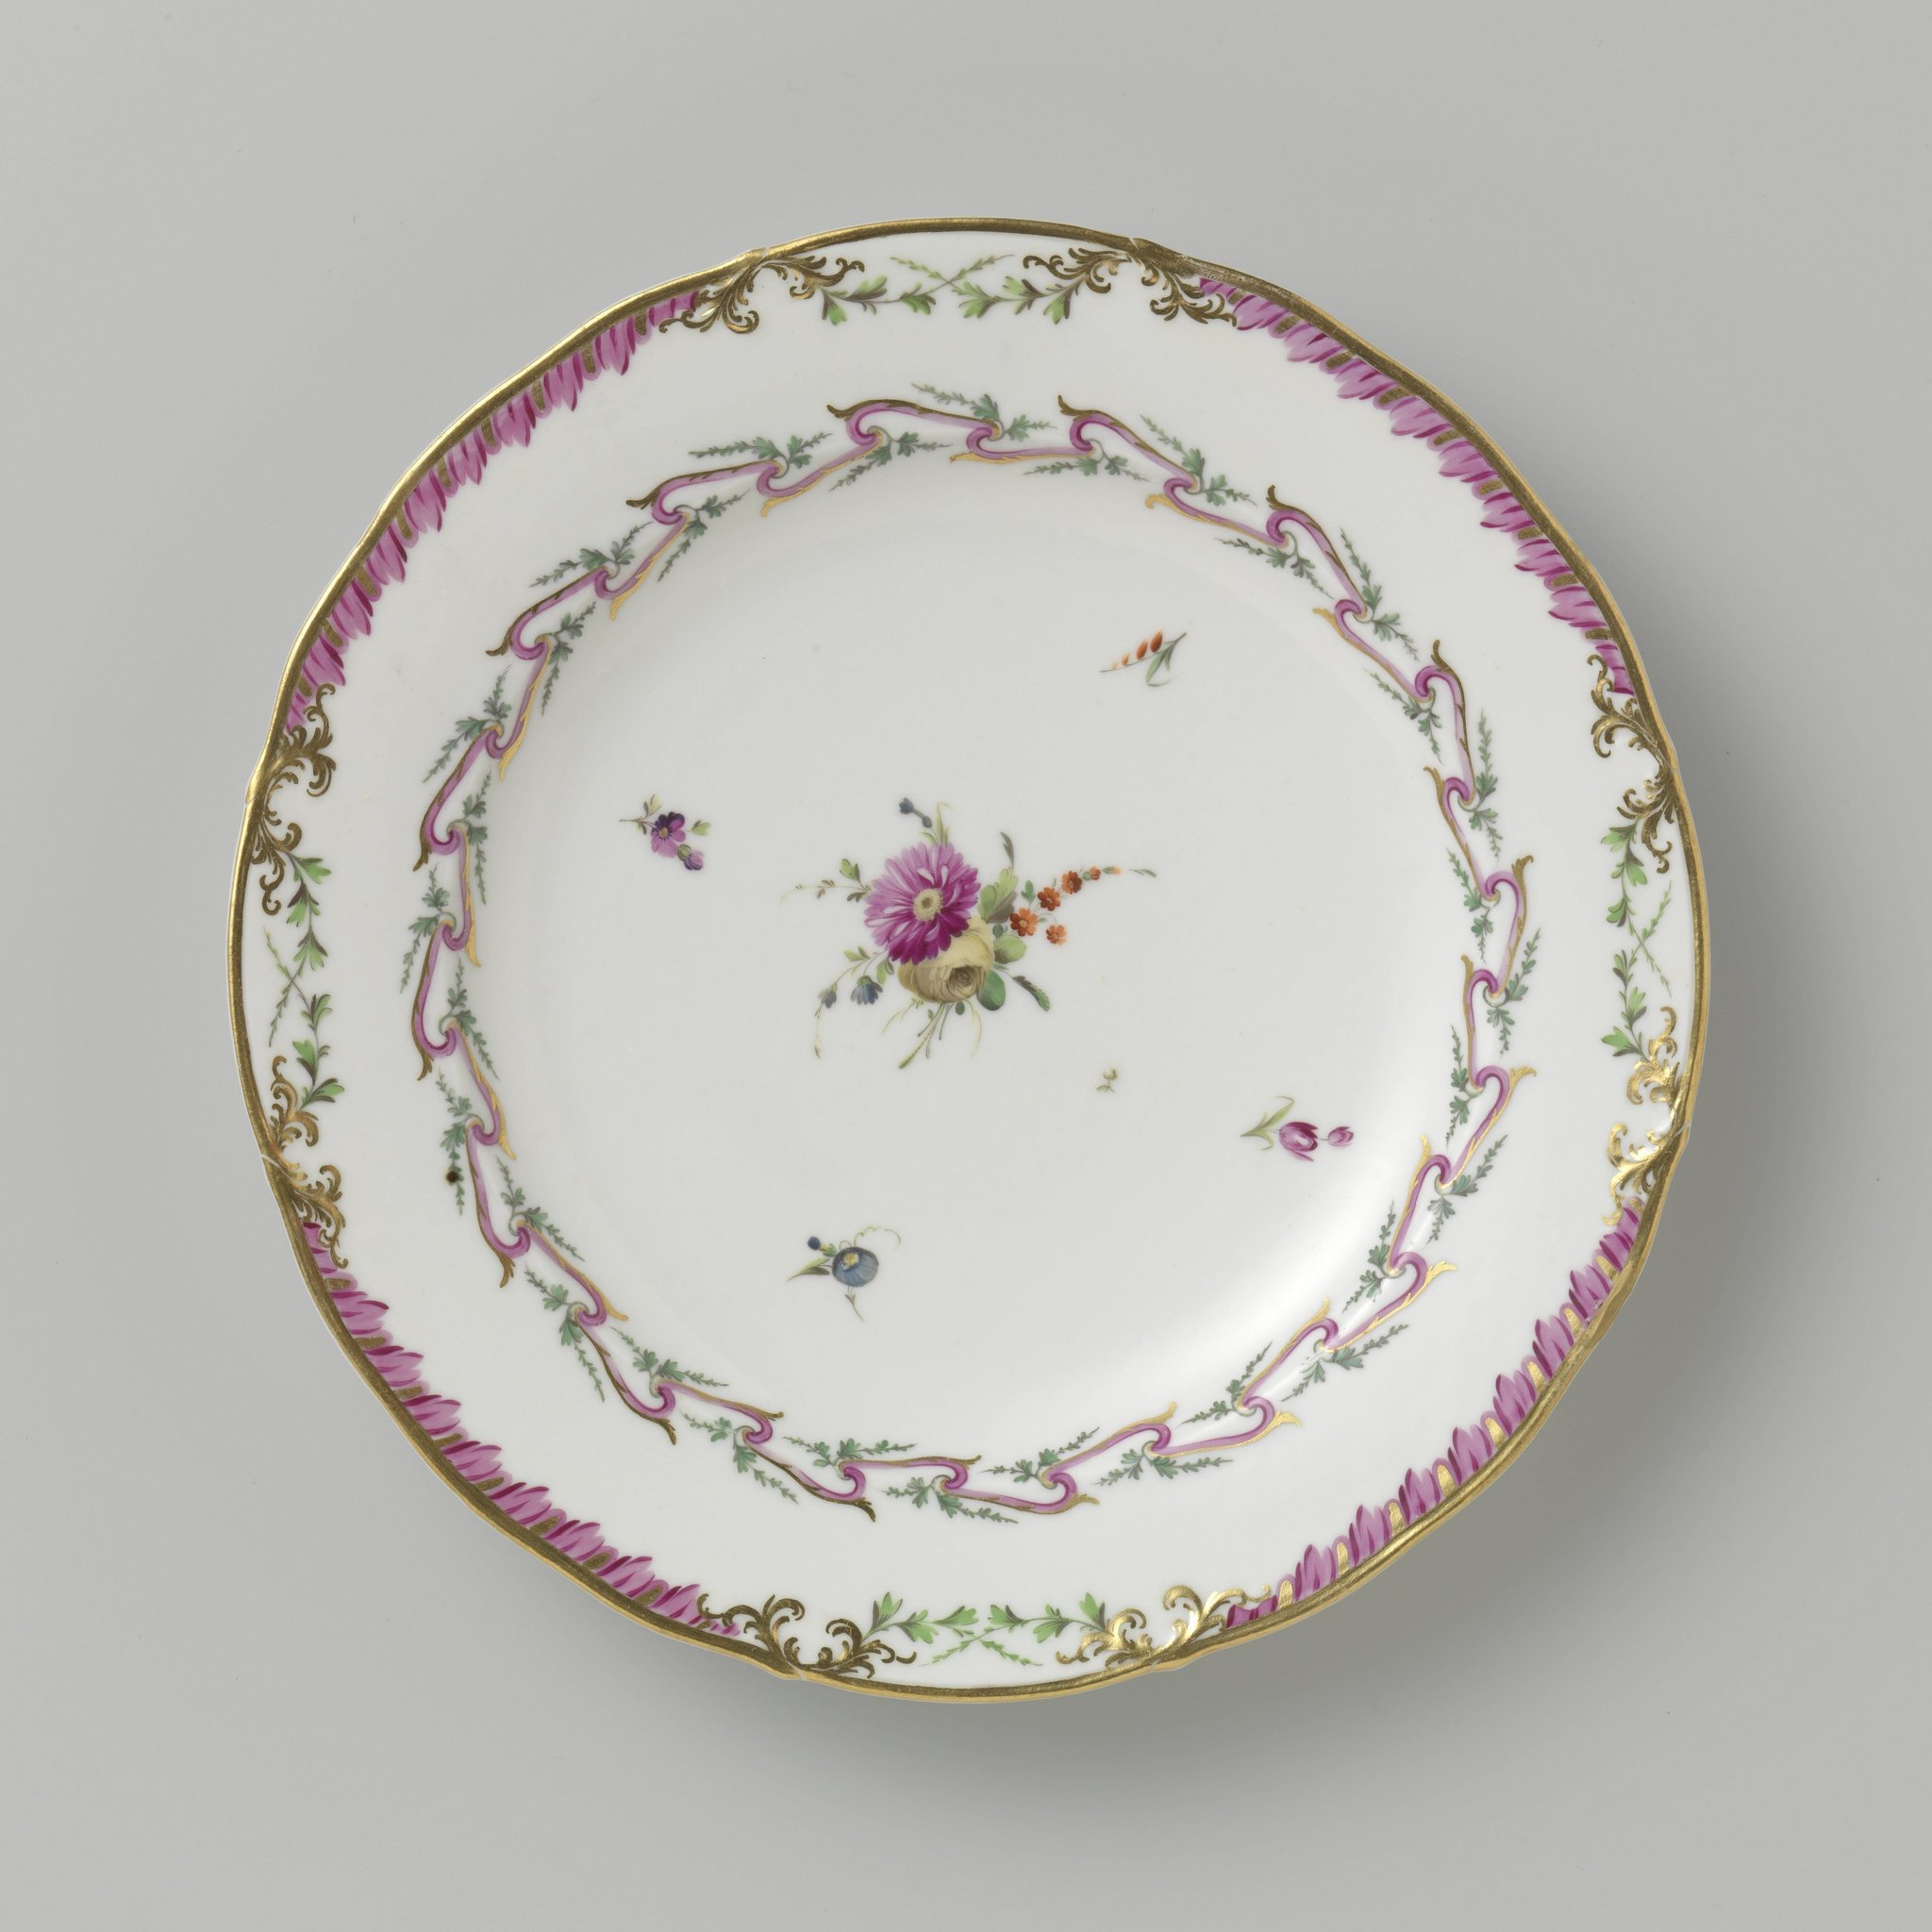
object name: plate dish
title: Bord, plat model, behorend bij een servies met geslingerd lintmotief met bladertakken, bloemboeketten en gestrooide bloemtakken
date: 1780-1820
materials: porcelain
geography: amsterdam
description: Bord, plat model, behorend bij een servies van porselein met geslingerd lintmotief in paars en goud met groene bladertakken, bloemboeketten en gestrooide bloemtakken. Randen lichtgegolfd met decoratie in goud met paars bladmotief waartussen groen gekruist bladmotief. Gemerkt: M.O.L. of AMSTEL.